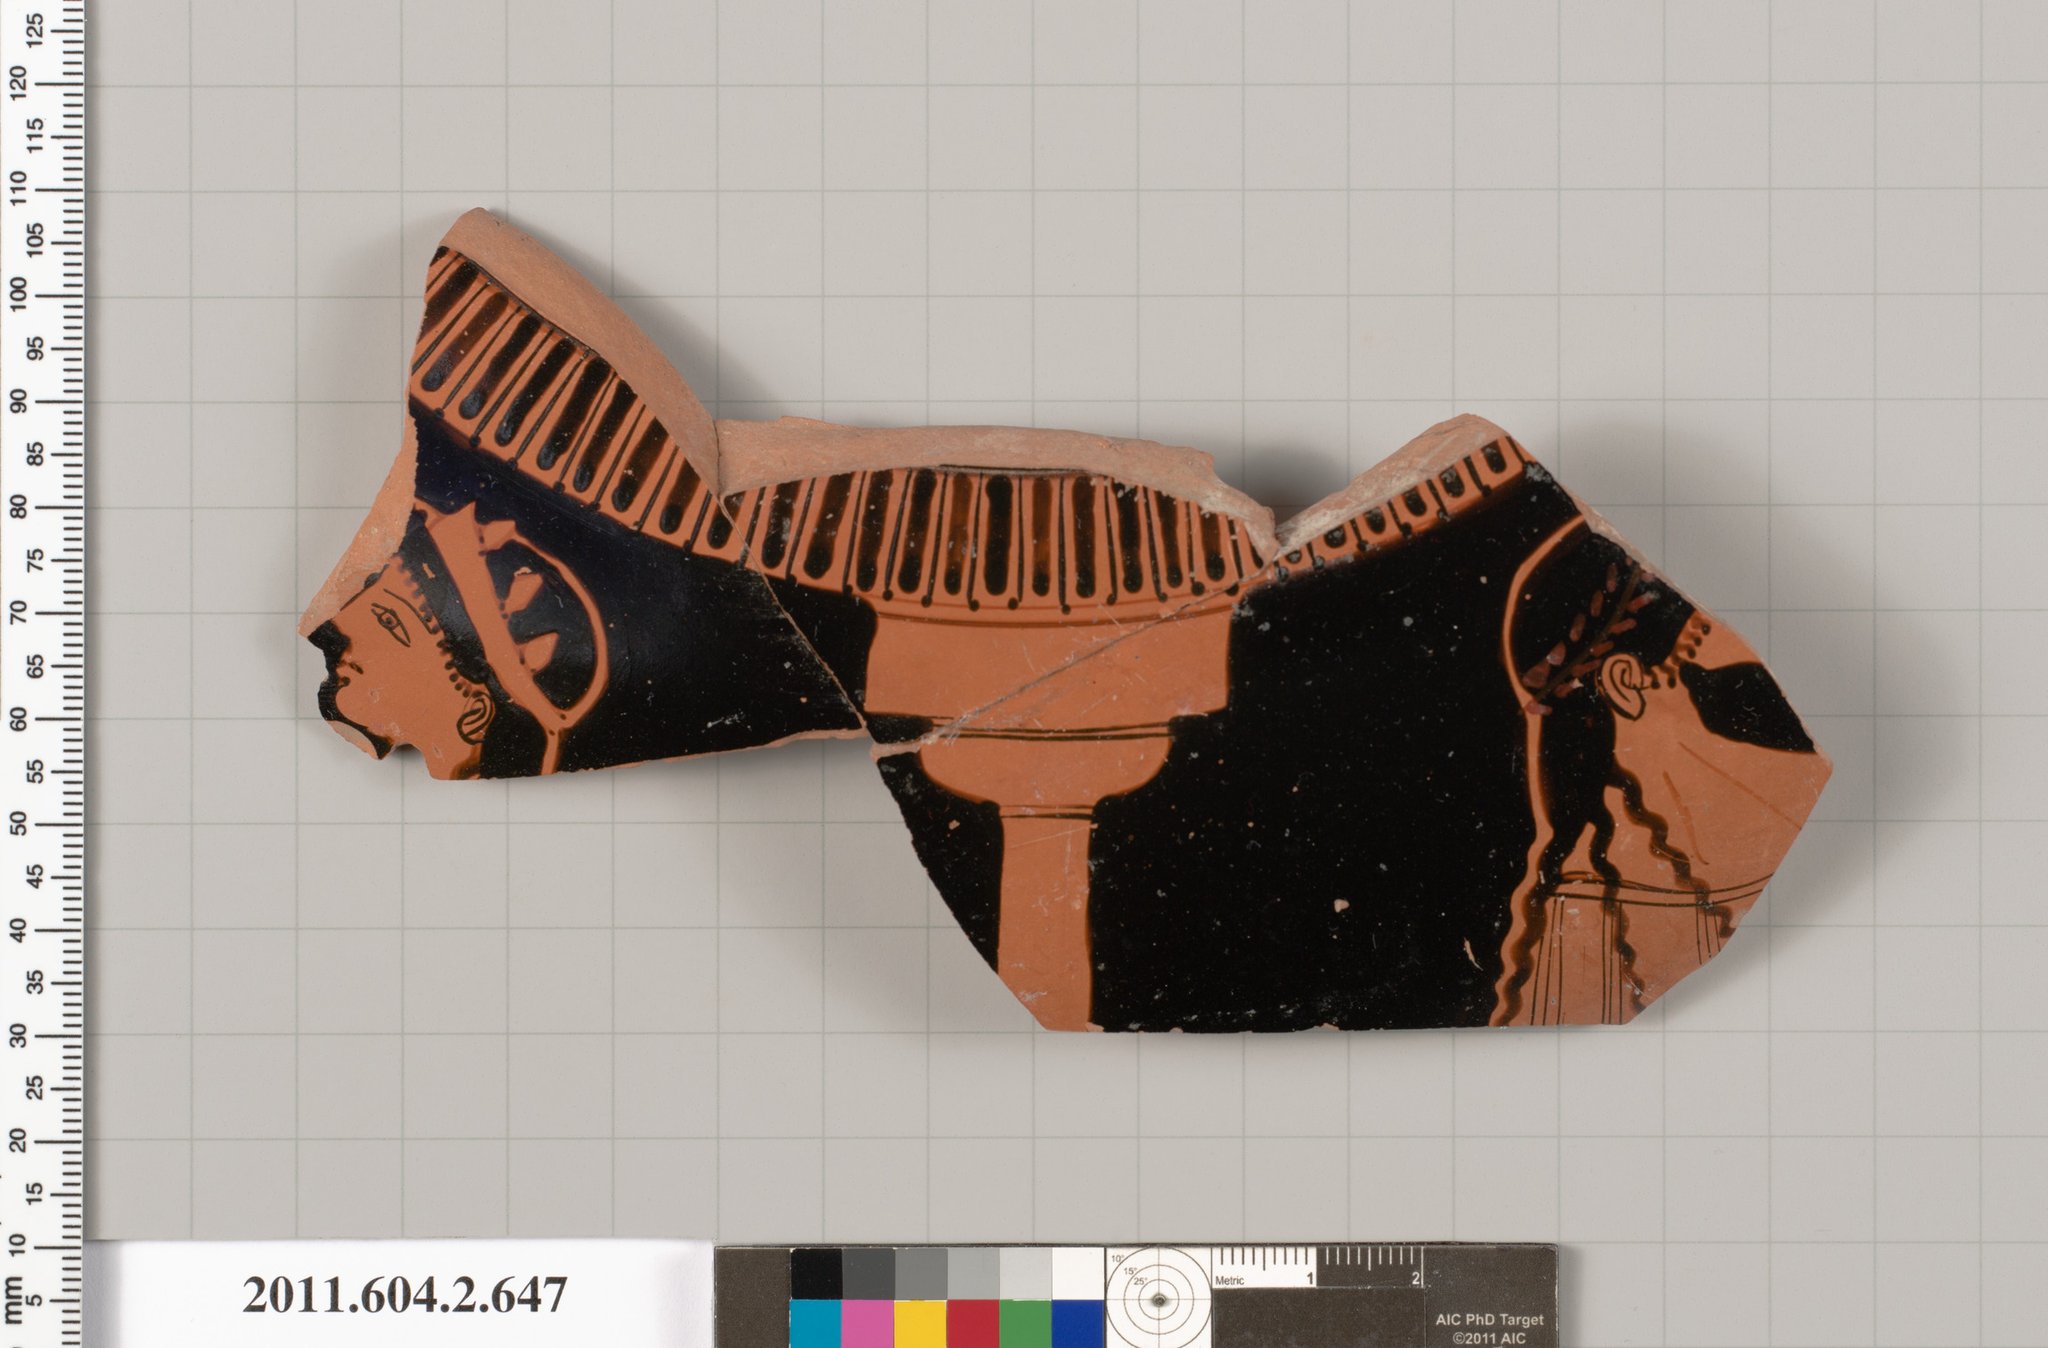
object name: stamnos or column krater fragment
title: Terracotta fragment of a stamnos (jar) or a column-krater (bowl for mixing wine and water)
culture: greek, attic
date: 490-480 BCE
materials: terracotta